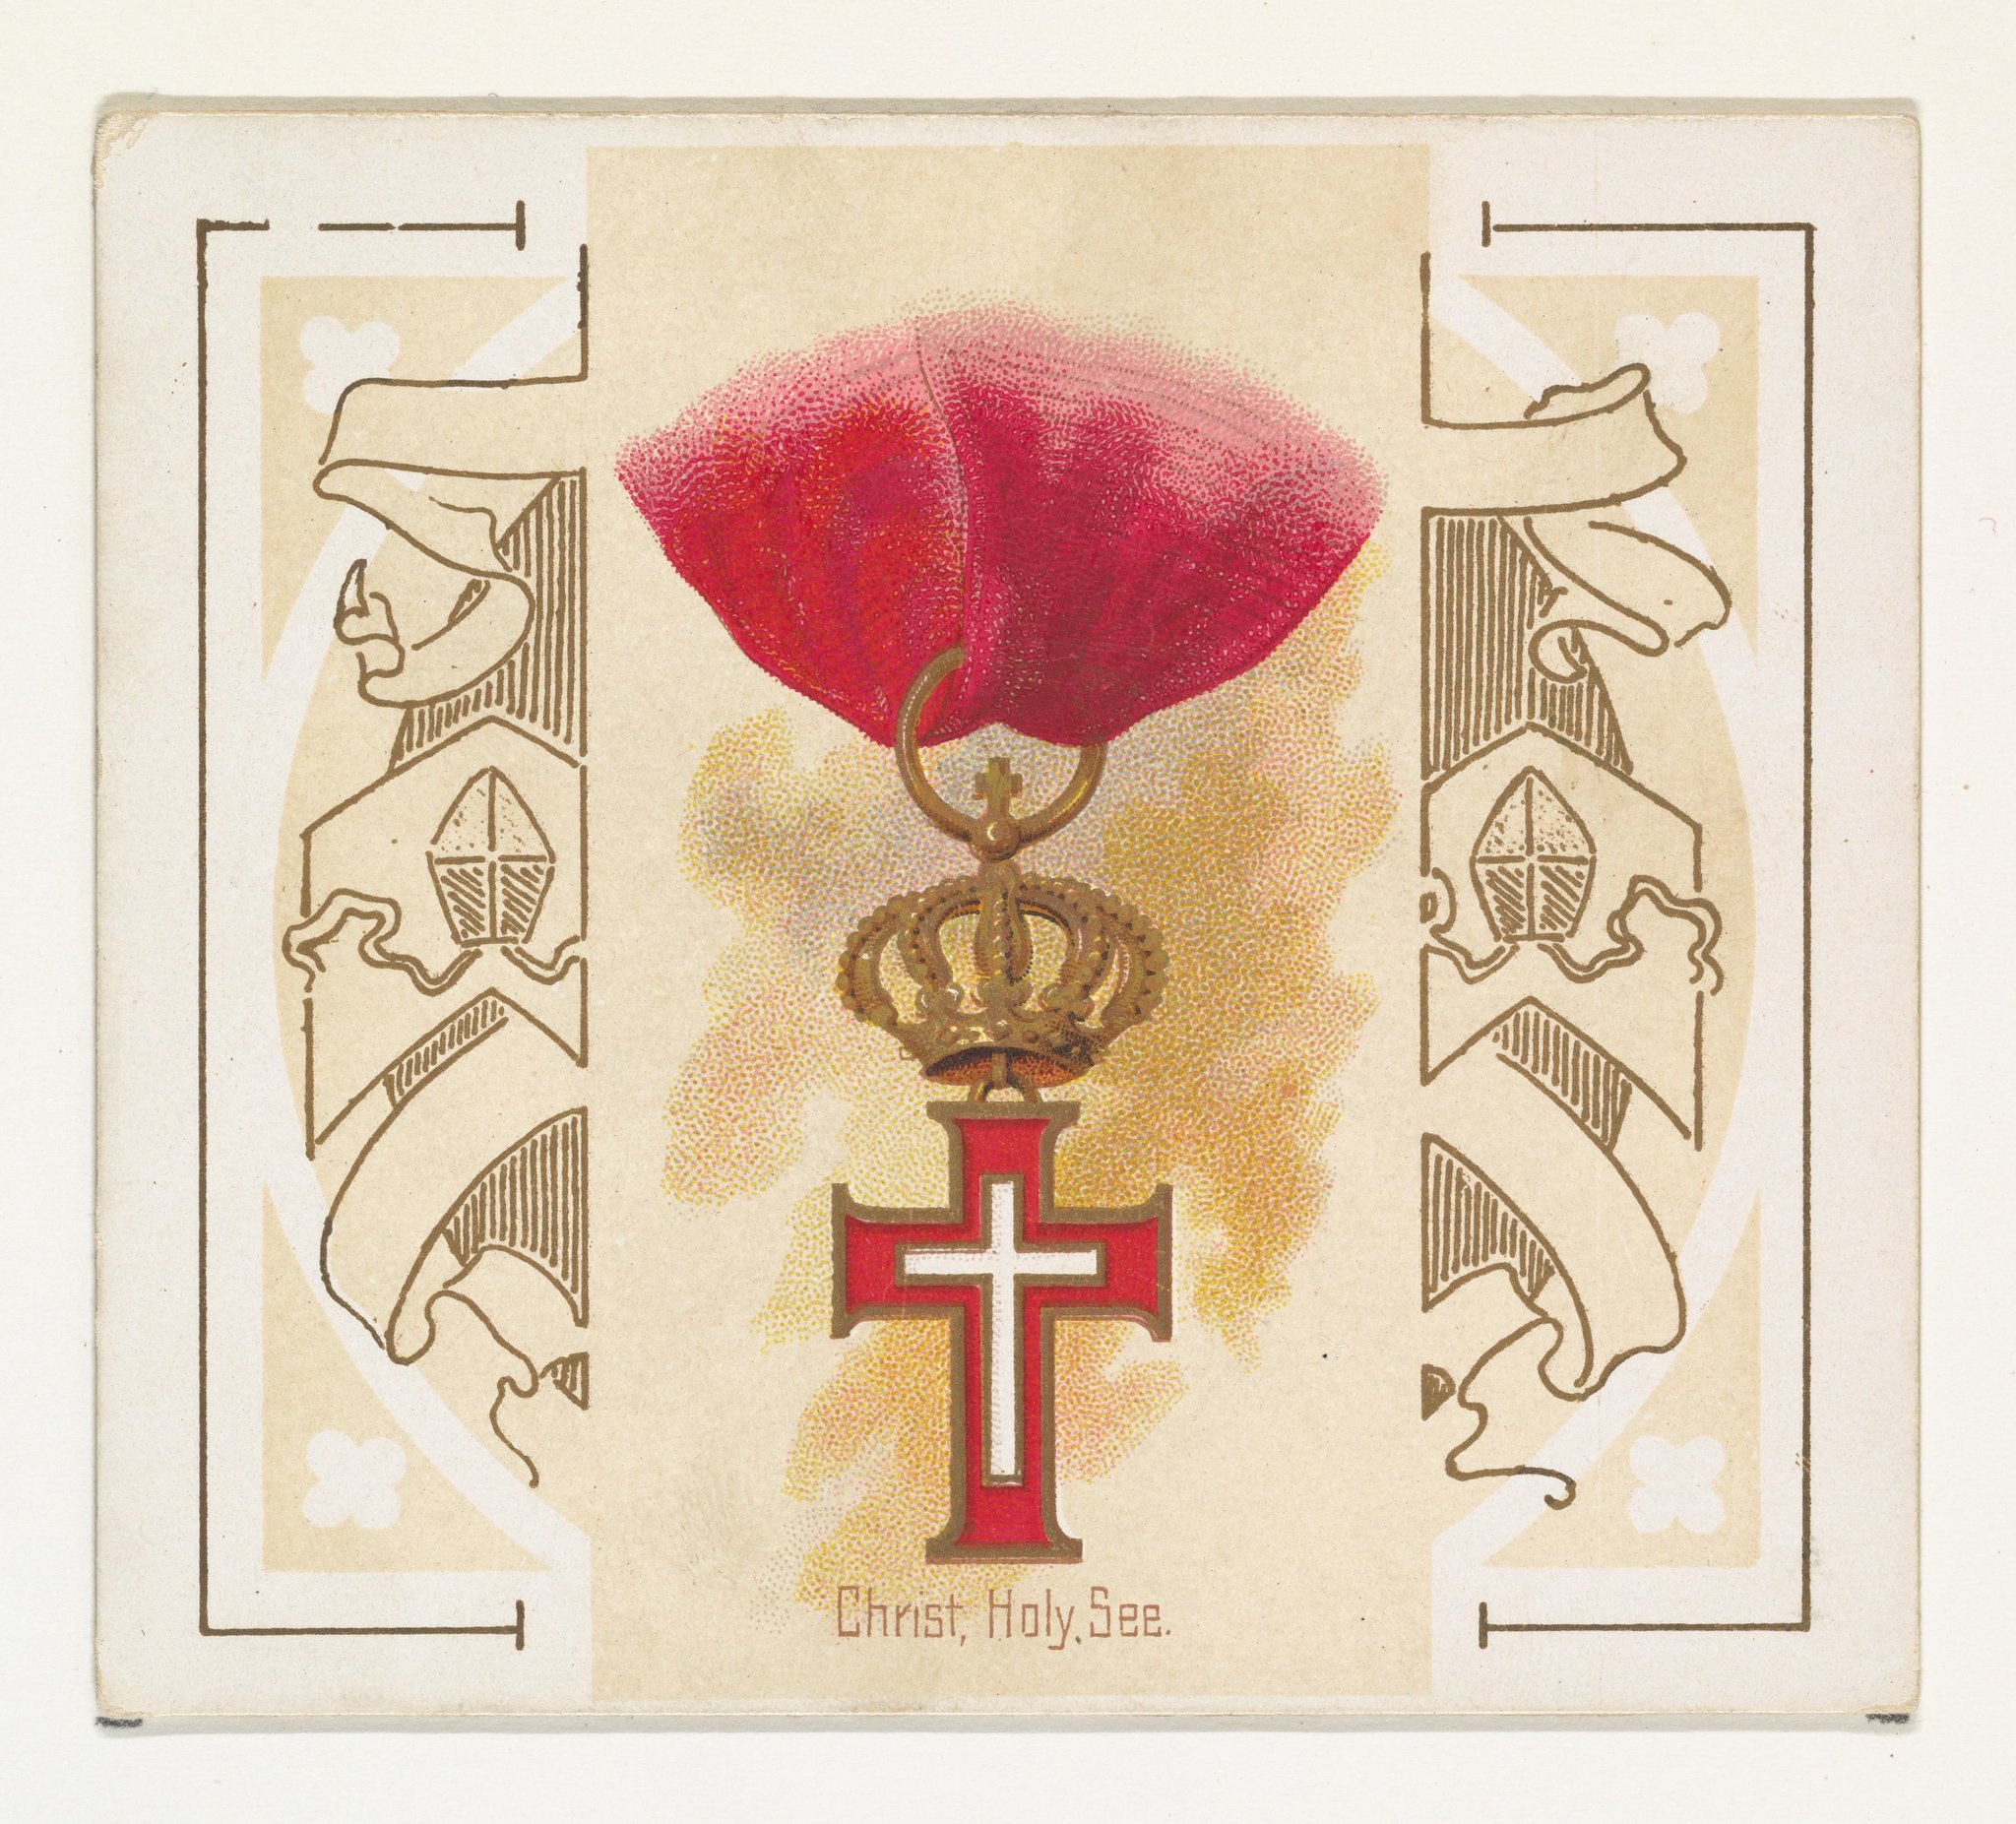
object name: print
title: Christ, Holy, See, from the World's Decorations series (N44) for Allen & Ginter Cigarettes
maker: allen & ginter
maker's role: publisher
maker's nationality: american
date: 1890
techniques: color lithograph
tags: medals